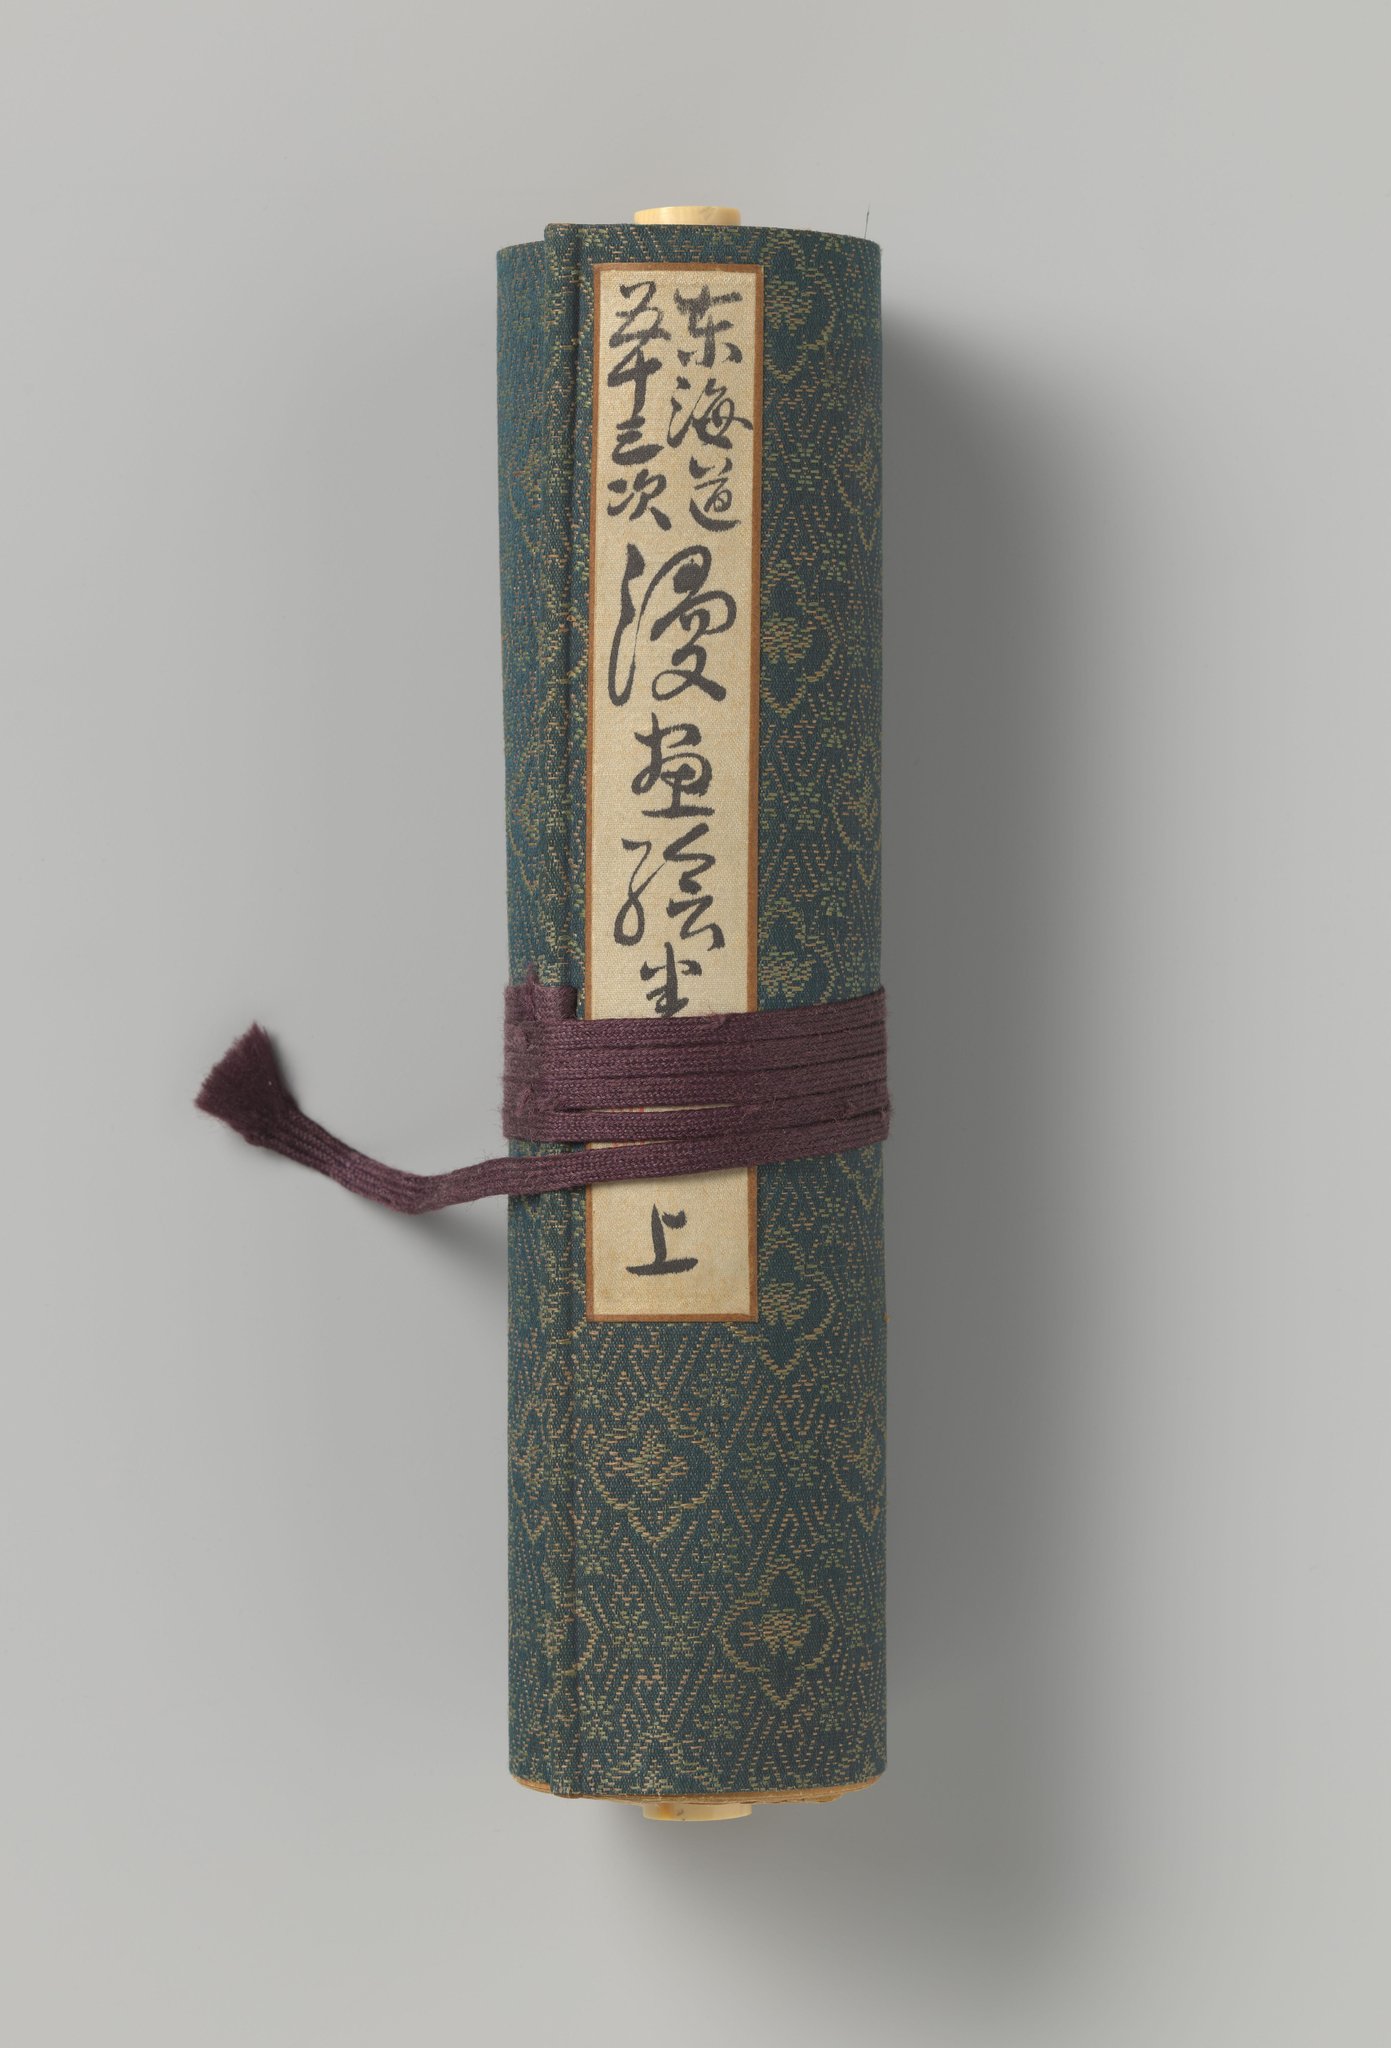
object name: hanging scroll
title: Handrol in doos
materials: paint, paper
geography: japan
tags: japan